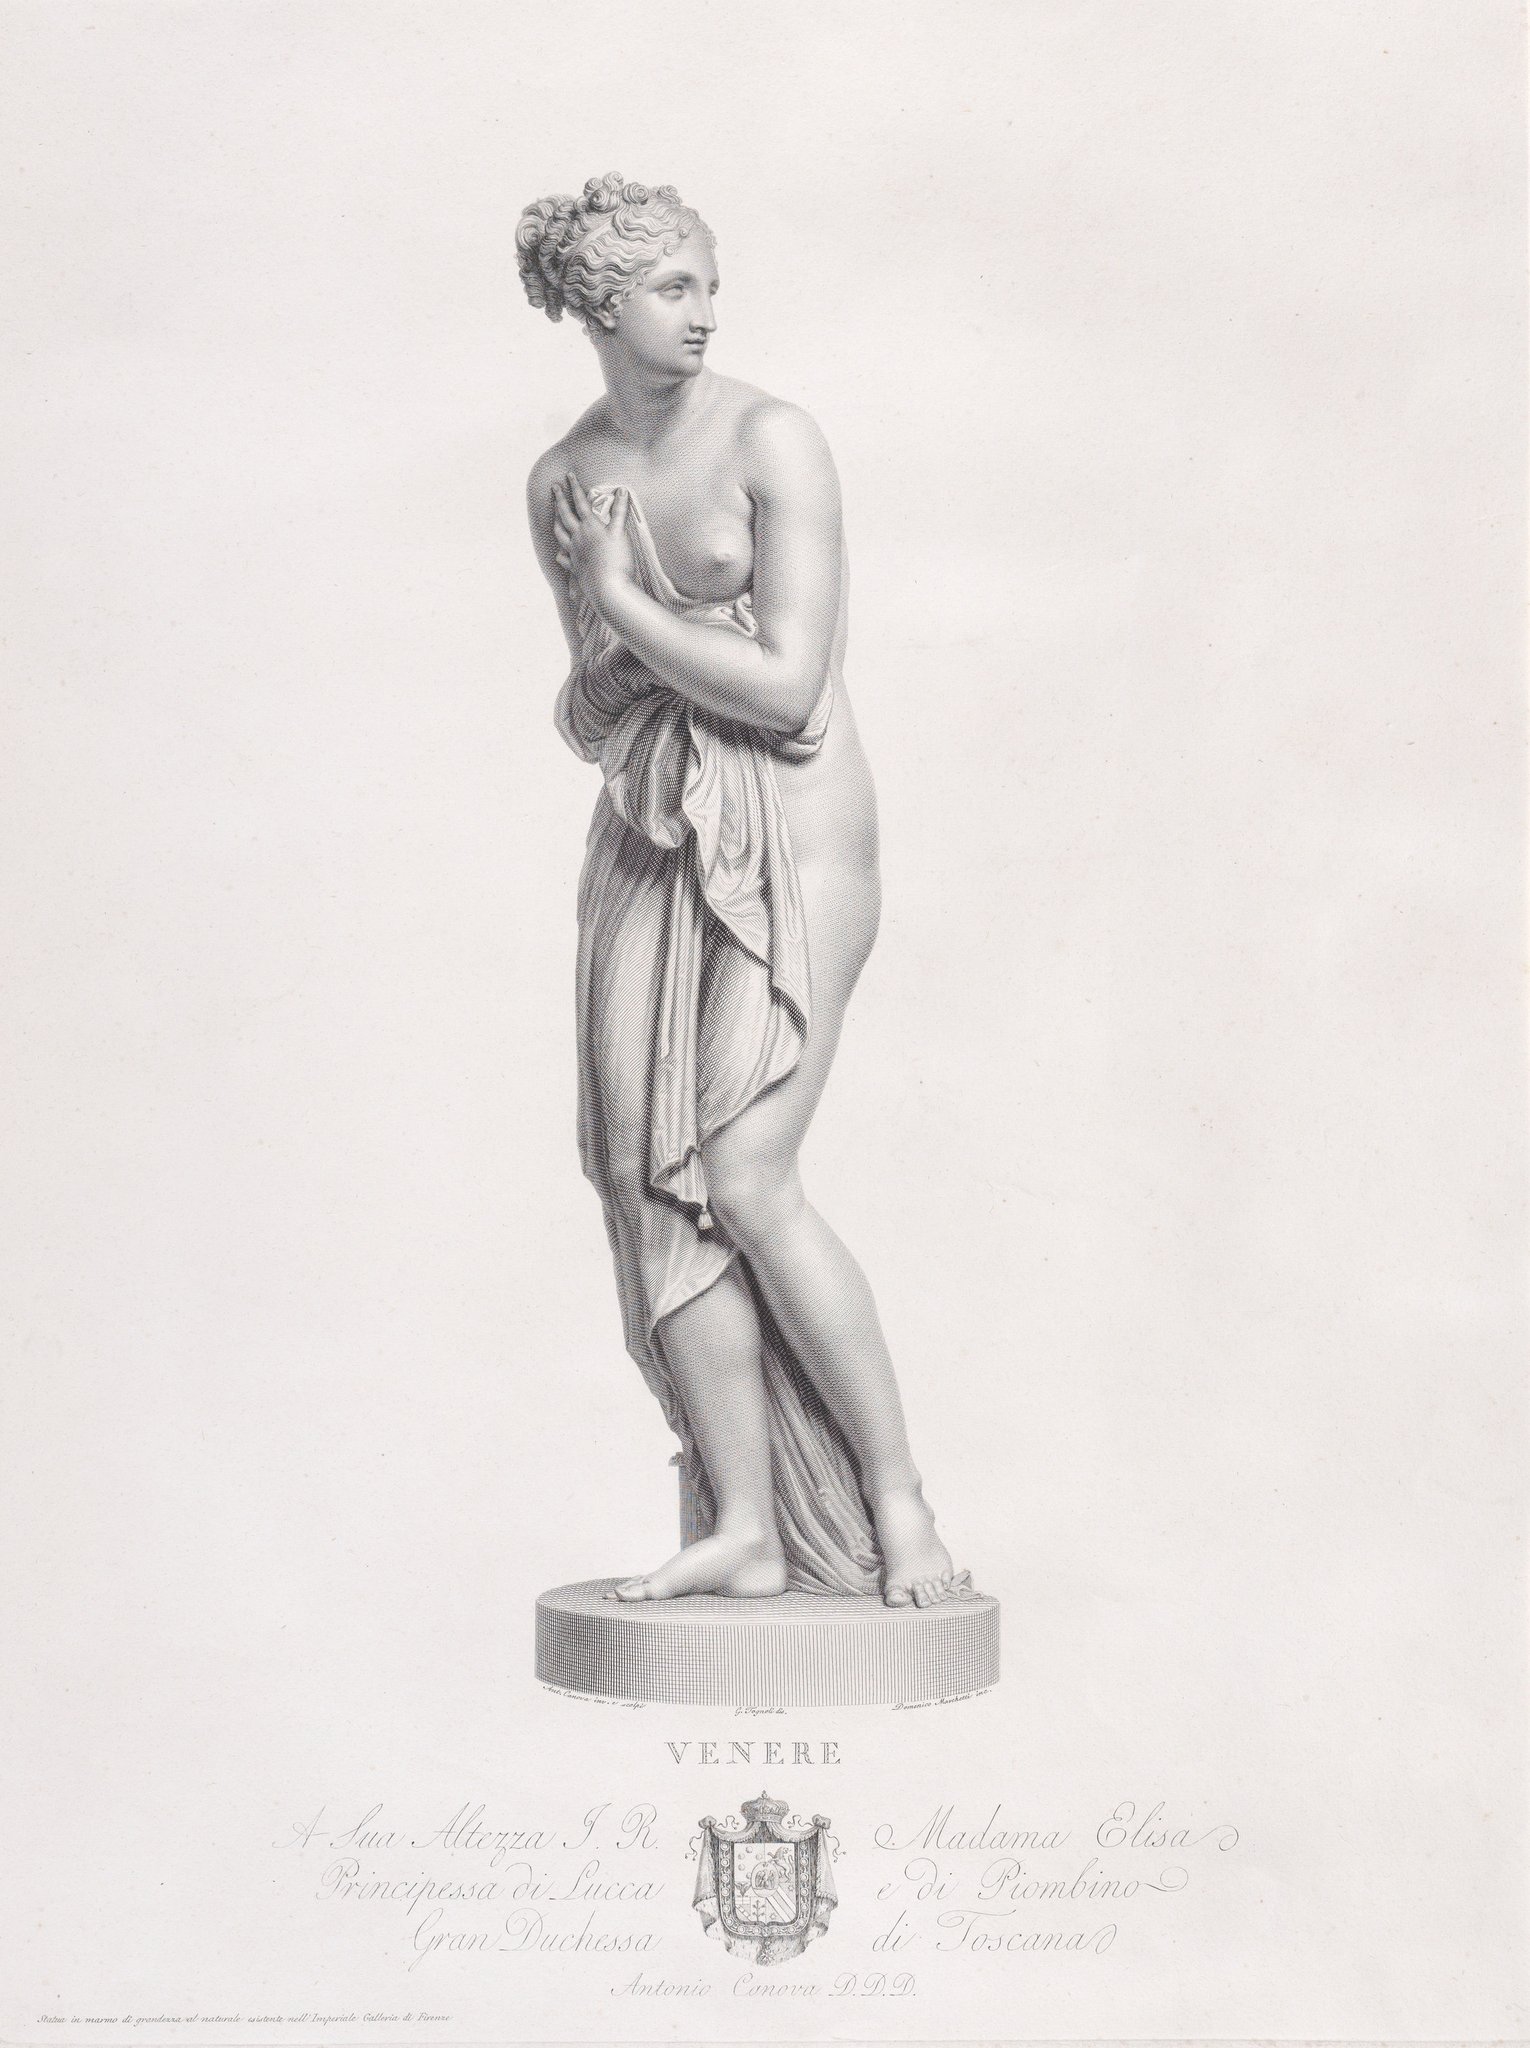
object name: print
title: Venus, frontal view, from "Oeuvre de Canova: Recueil de Statues..."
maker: domenico marchetti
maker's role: artist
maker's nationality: italian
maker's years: 1780-1844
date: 1817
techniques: engraving, etching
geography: rome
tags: female nudes,venus